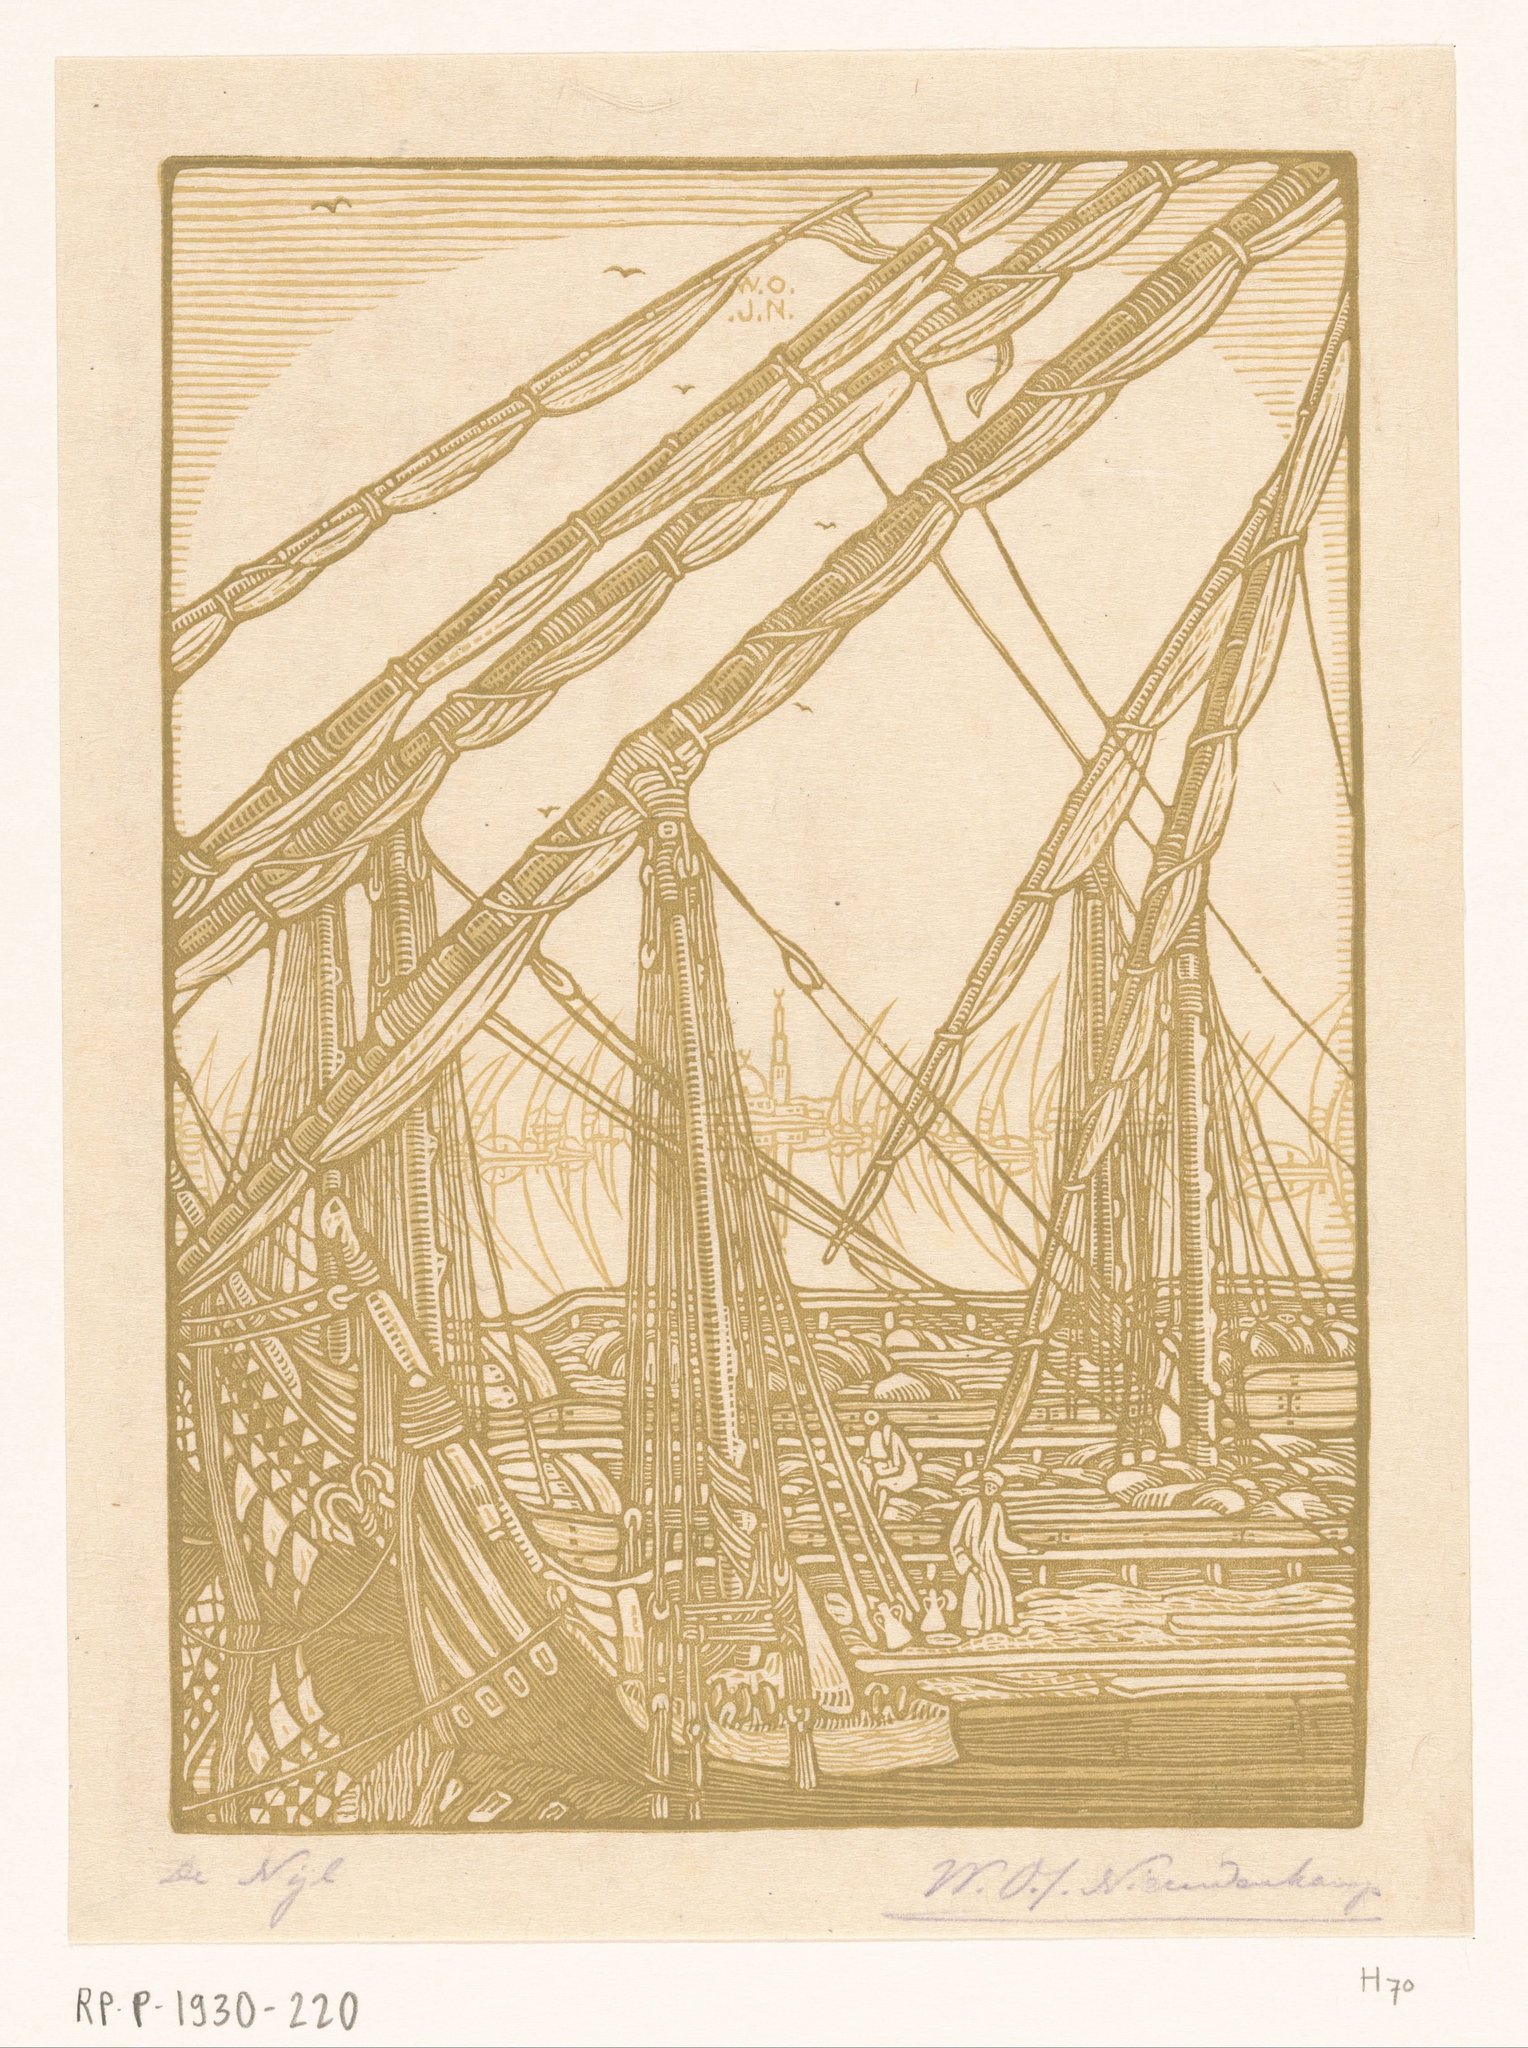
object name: print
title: De Nijl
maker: wijnand otto jan nieuwenkamp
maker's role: draughtsman, print maker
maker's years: 1874-1950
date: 1905-1910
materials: paper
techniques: woodcut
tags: sailing-ship, sailing-boat, river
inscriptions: collector's mark: Lugt 2228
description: Op de achtergrond een moskee op een over.